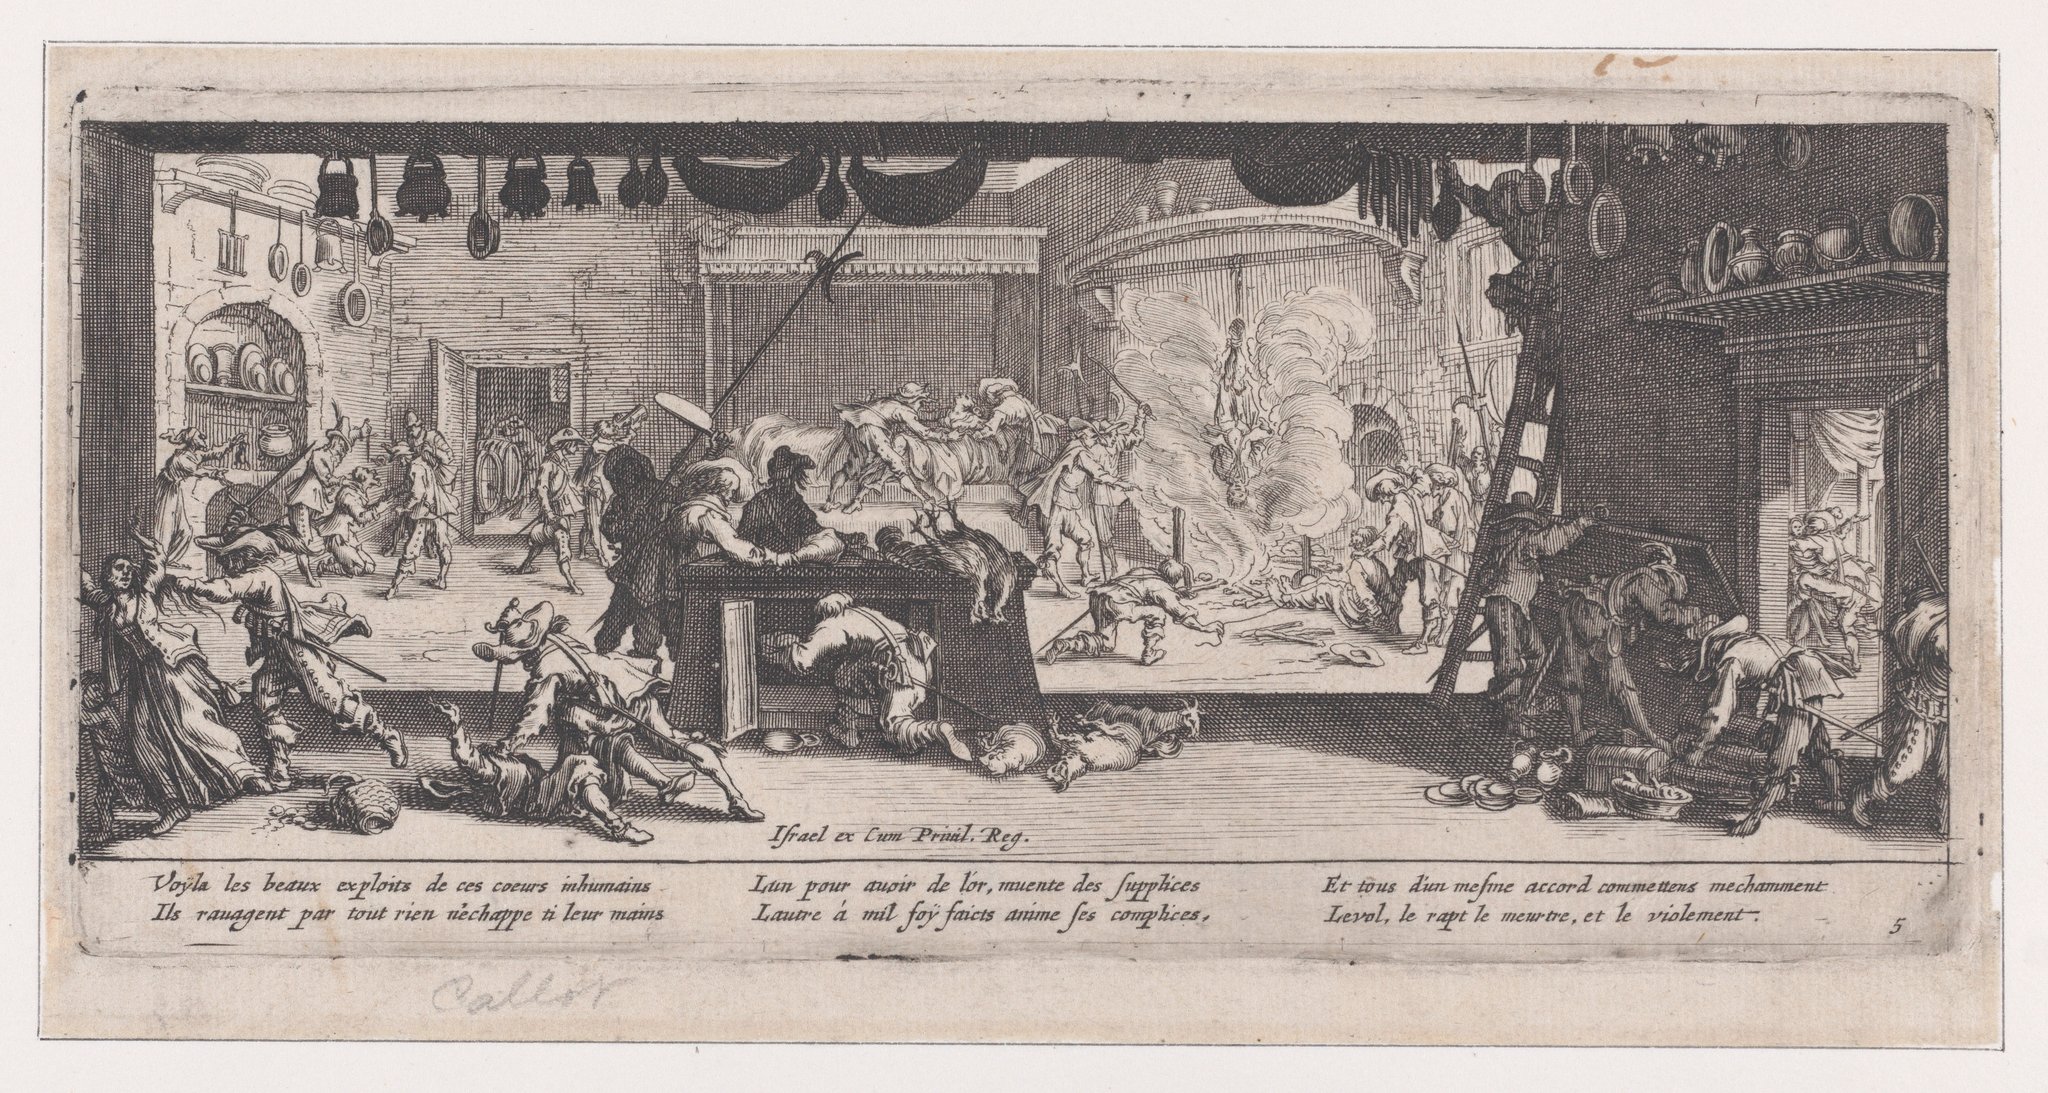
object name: print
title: Le Pillage d'une Ferme (The Looting of a Farm), from Les Misères et les Mal-Heures de la Guerre (The Miseries and Misfortunes of War), plate 5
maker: jacques callot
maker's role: artist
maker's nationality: french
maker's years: 1592-1635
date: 1633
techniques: etching